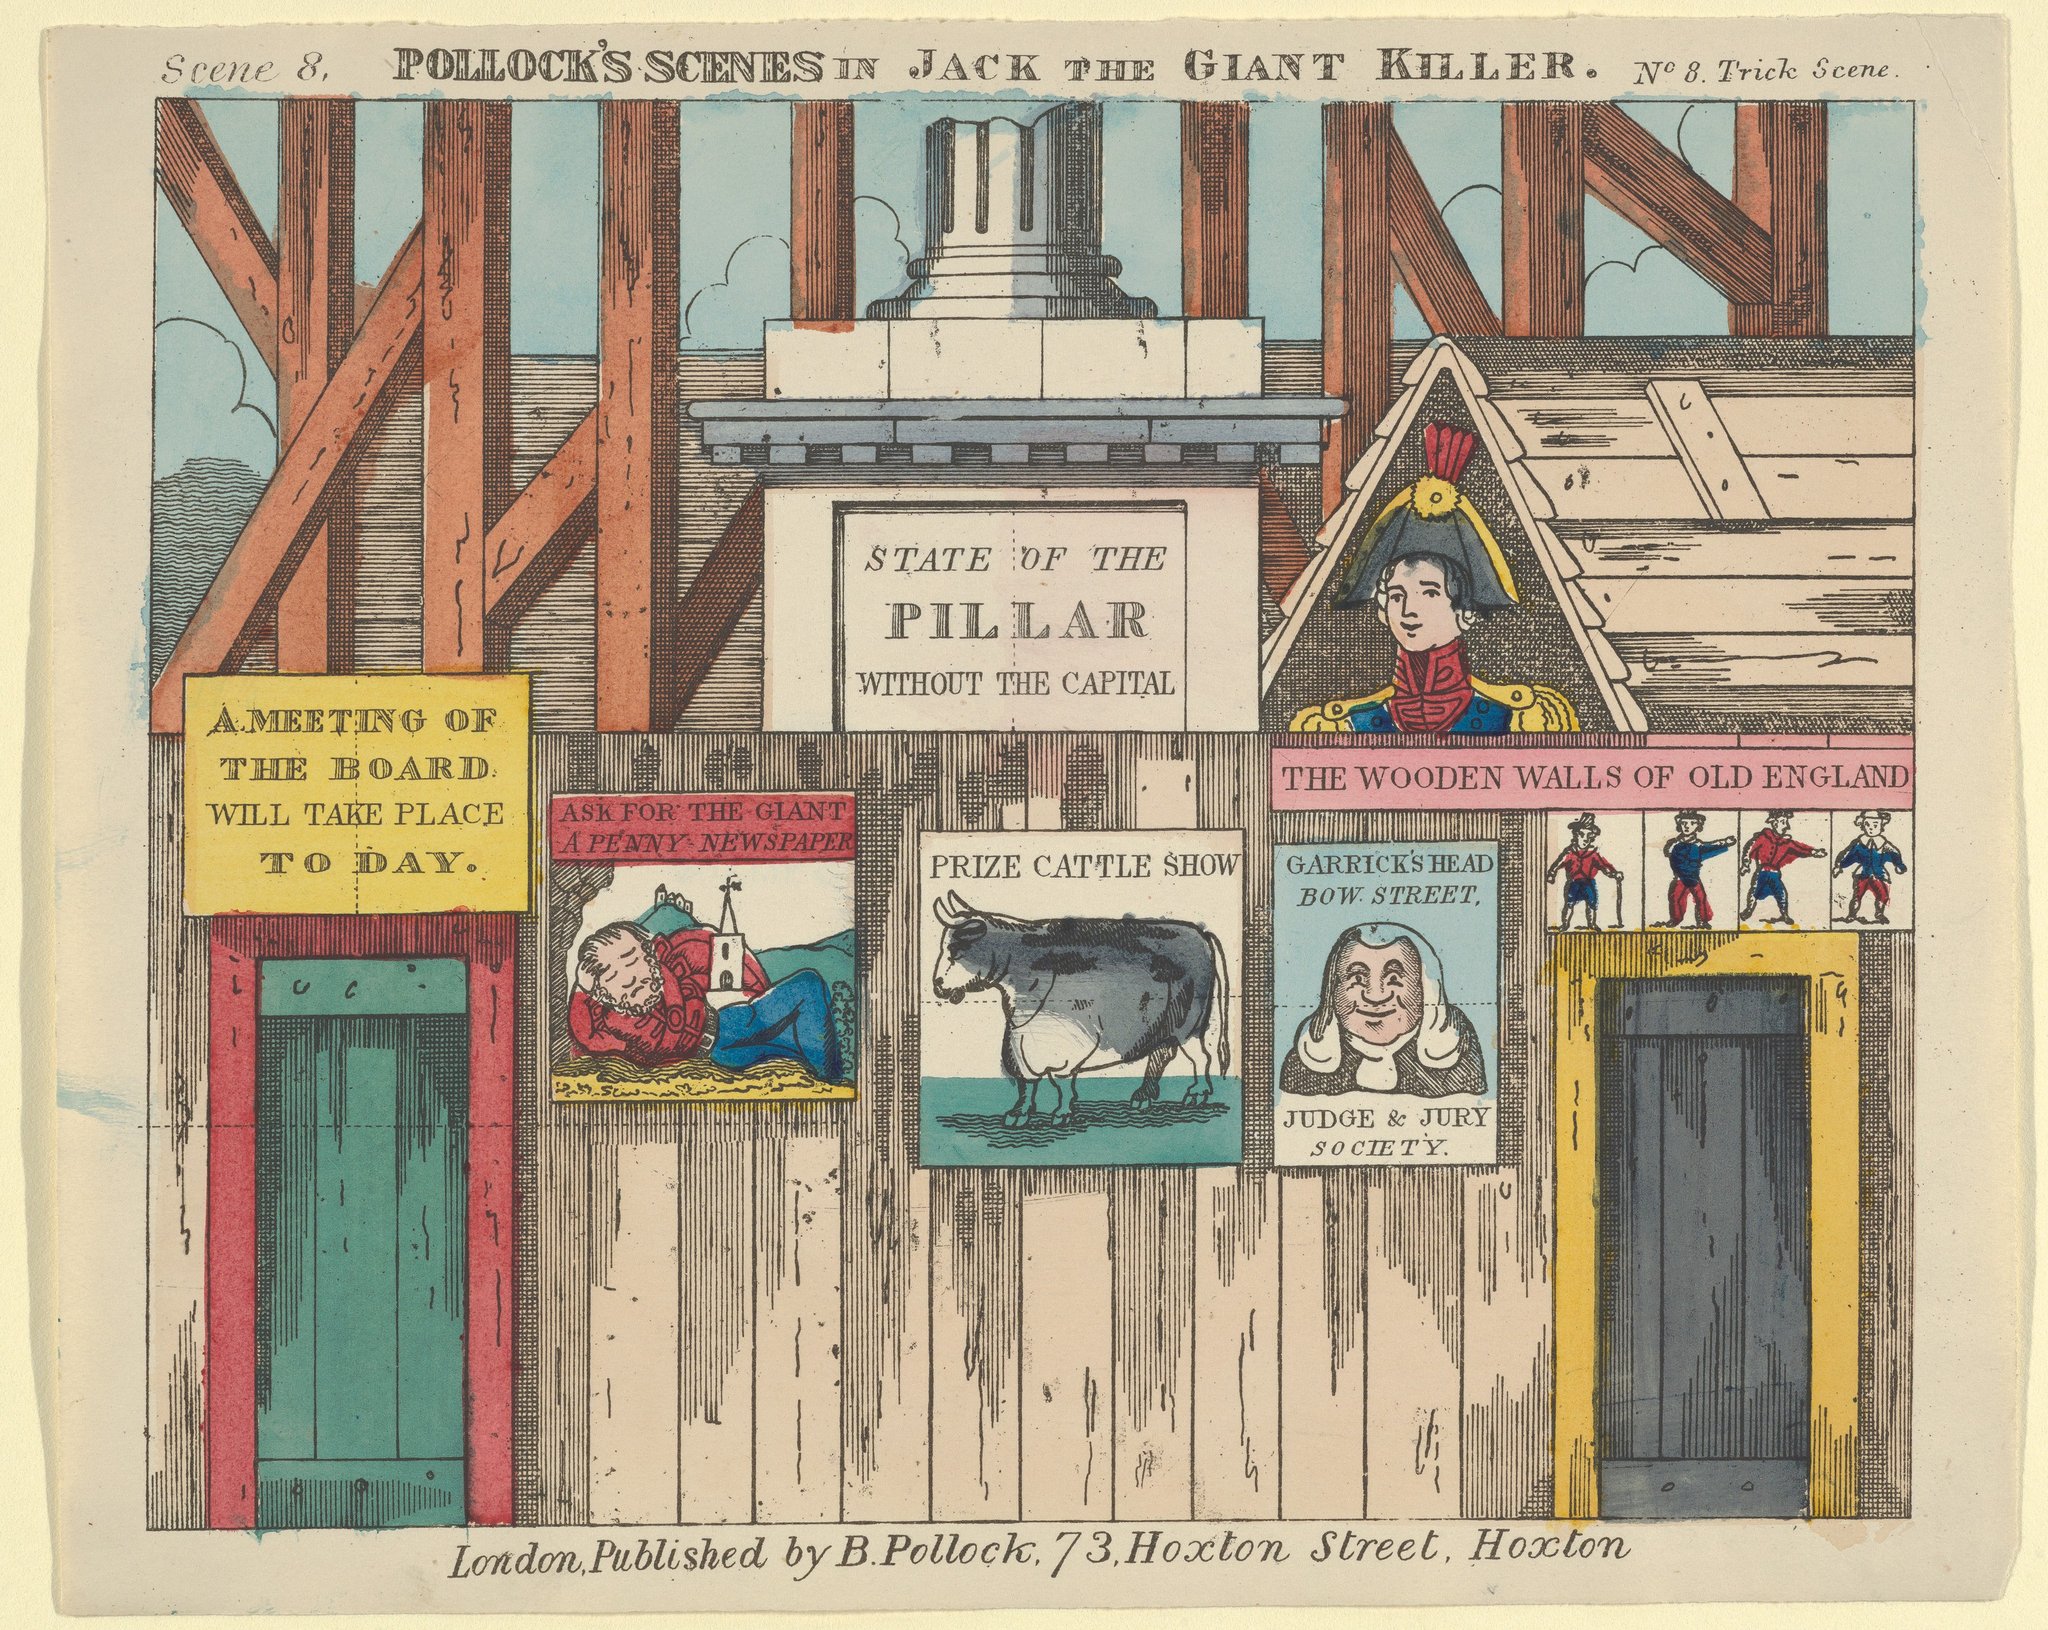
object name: print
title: Scene 8, from Jack and the Giant Killer, Scenes for a Toy Theater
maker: benjamin pollock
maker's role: publisher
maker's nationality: british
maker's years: 1857-1937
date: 1870-1890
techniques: lithograph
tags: animals,men